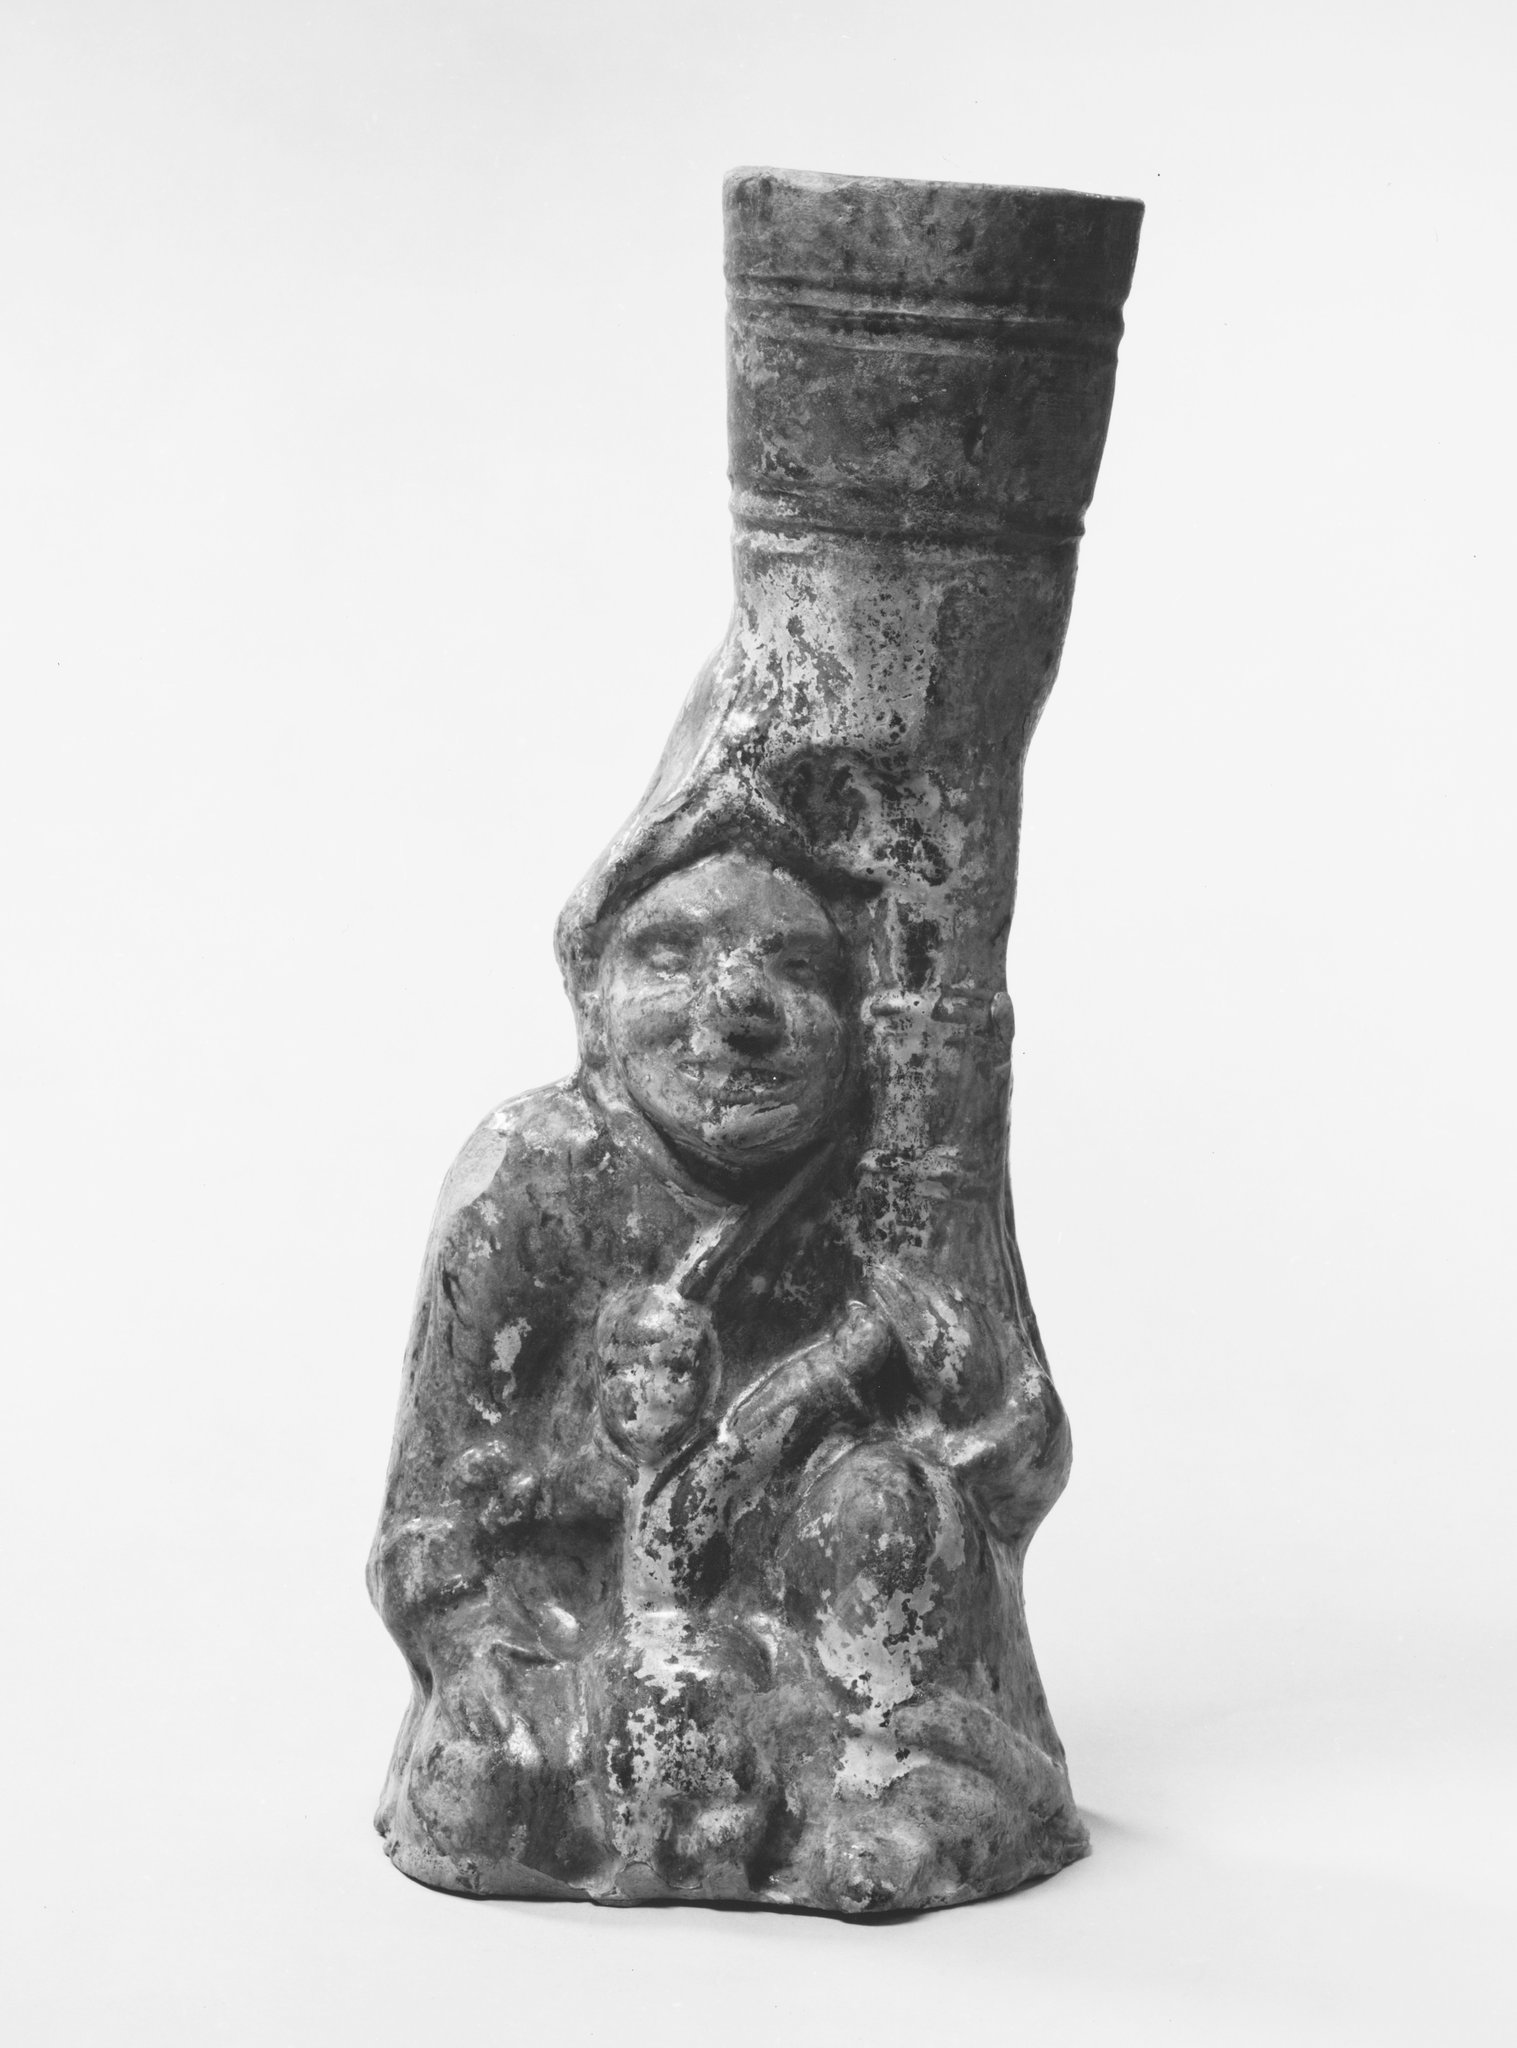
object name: candlestick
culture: chinese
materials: earthenware, glaze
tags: children,women